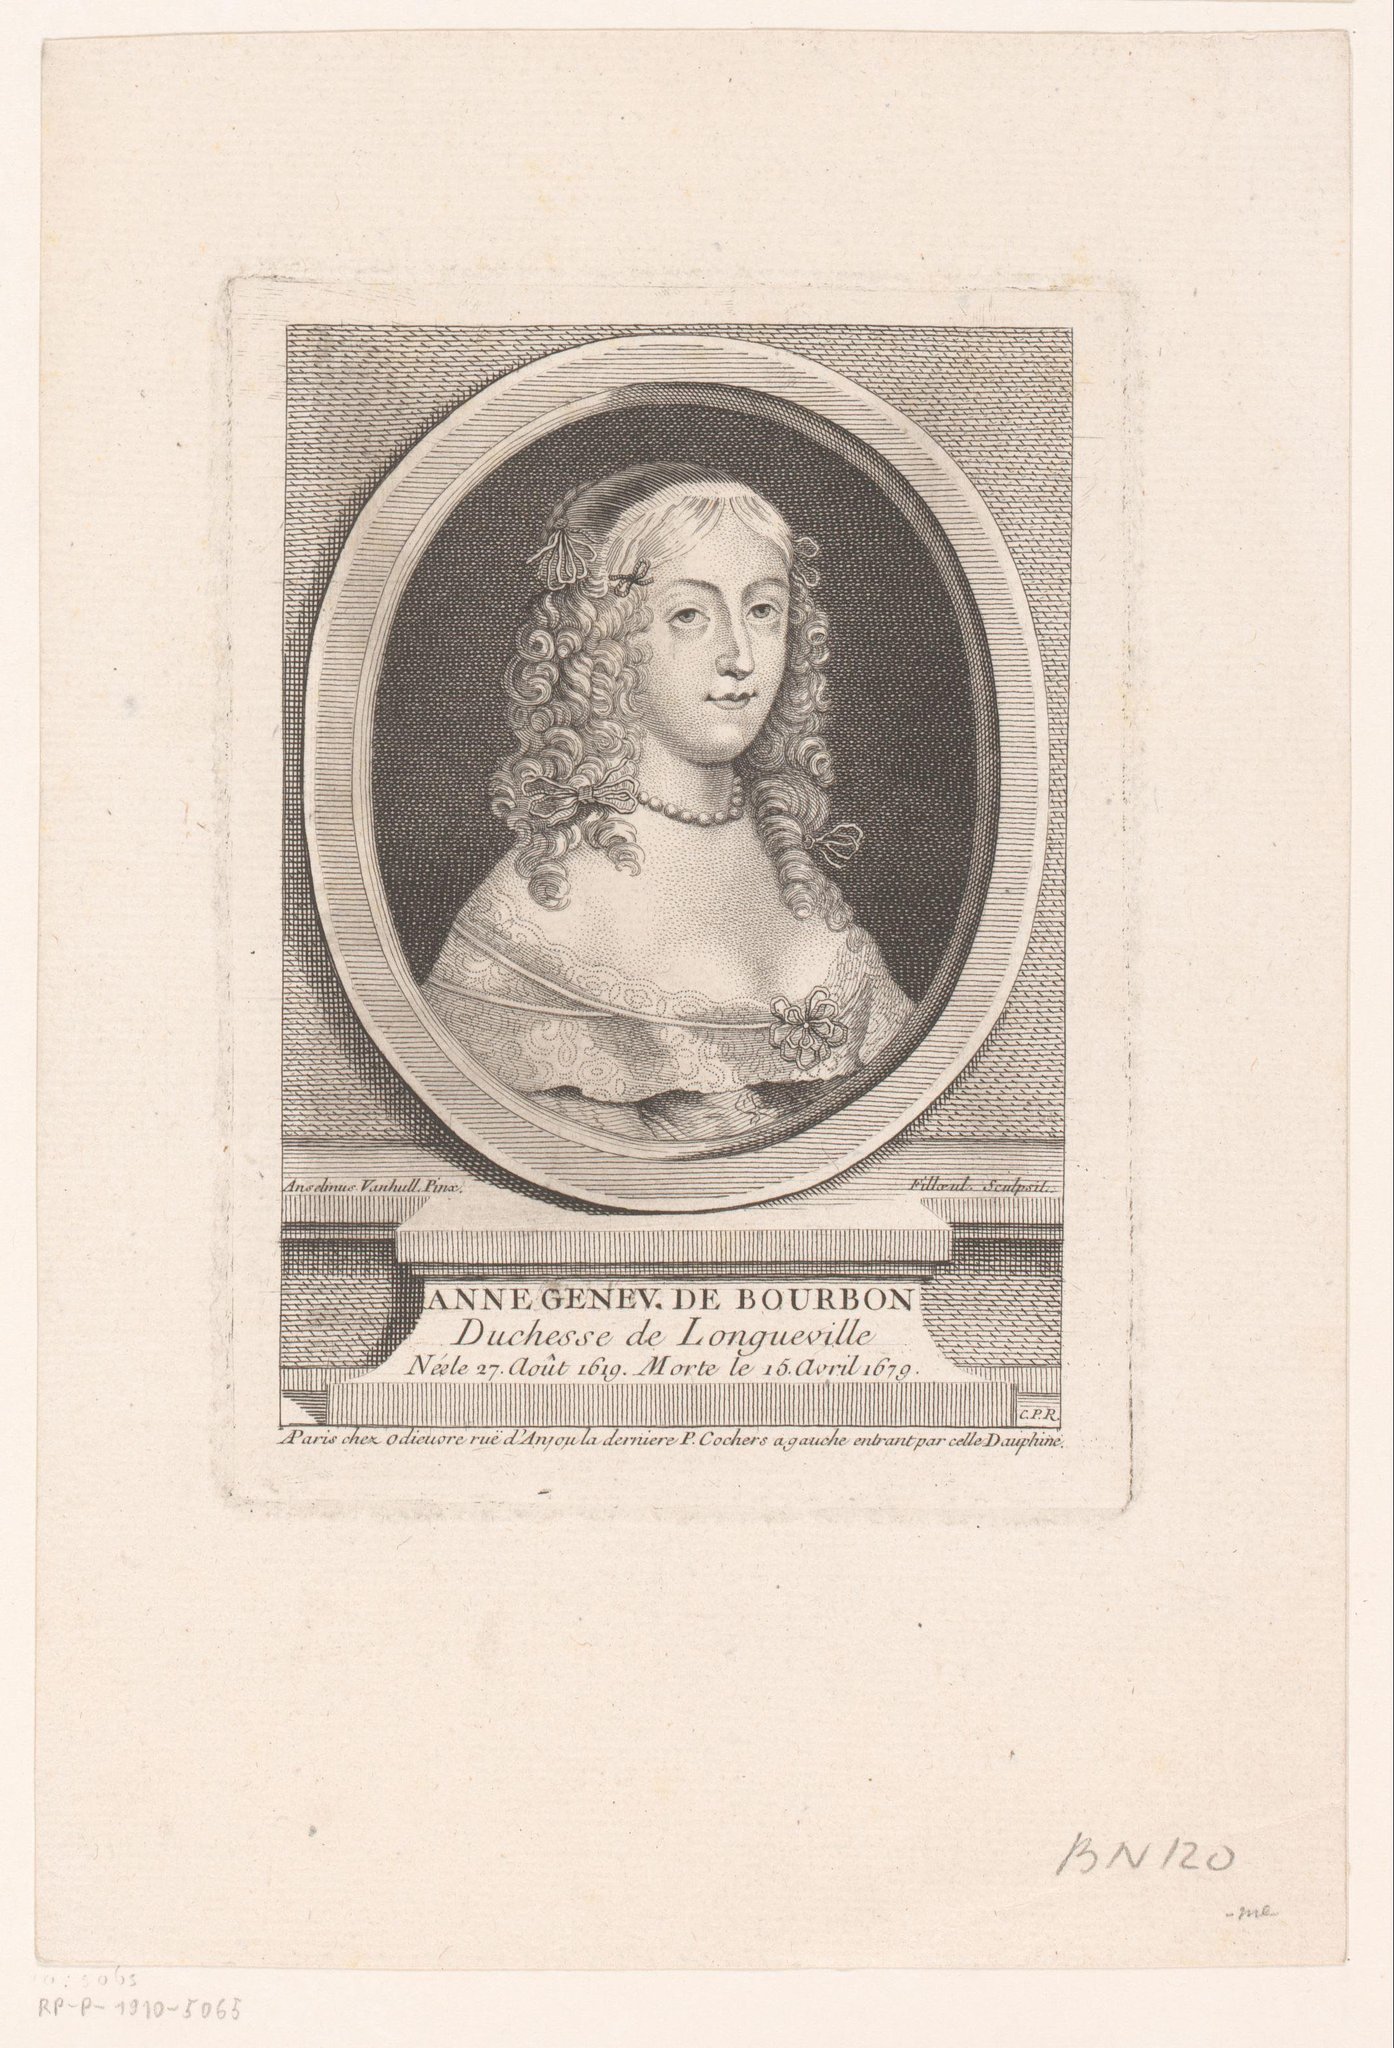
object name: print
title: Portret van Anna Genoveva van Bourbon-Condé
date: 1744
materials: paper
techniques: engraving, etching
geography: paris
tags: paris, anna genoveva van bourbon-condé, historical persons - bb - woman, ornament ~ medallion, ruler, sovereign - bb - female ruler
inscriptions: collector's mark: Lugt 2228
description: Prent uit: Dreux du Radier, Jean-François. L'Europe illustré, contenant l'histoire abregée des souverains, des princes, des prélats, des ministres, (...) en Europe: dans le XVe. siècle compris, jusqu'à présent. Parijs: Michel Odieuvre en Jean-Luc Nyon, 1755, dl. 2.